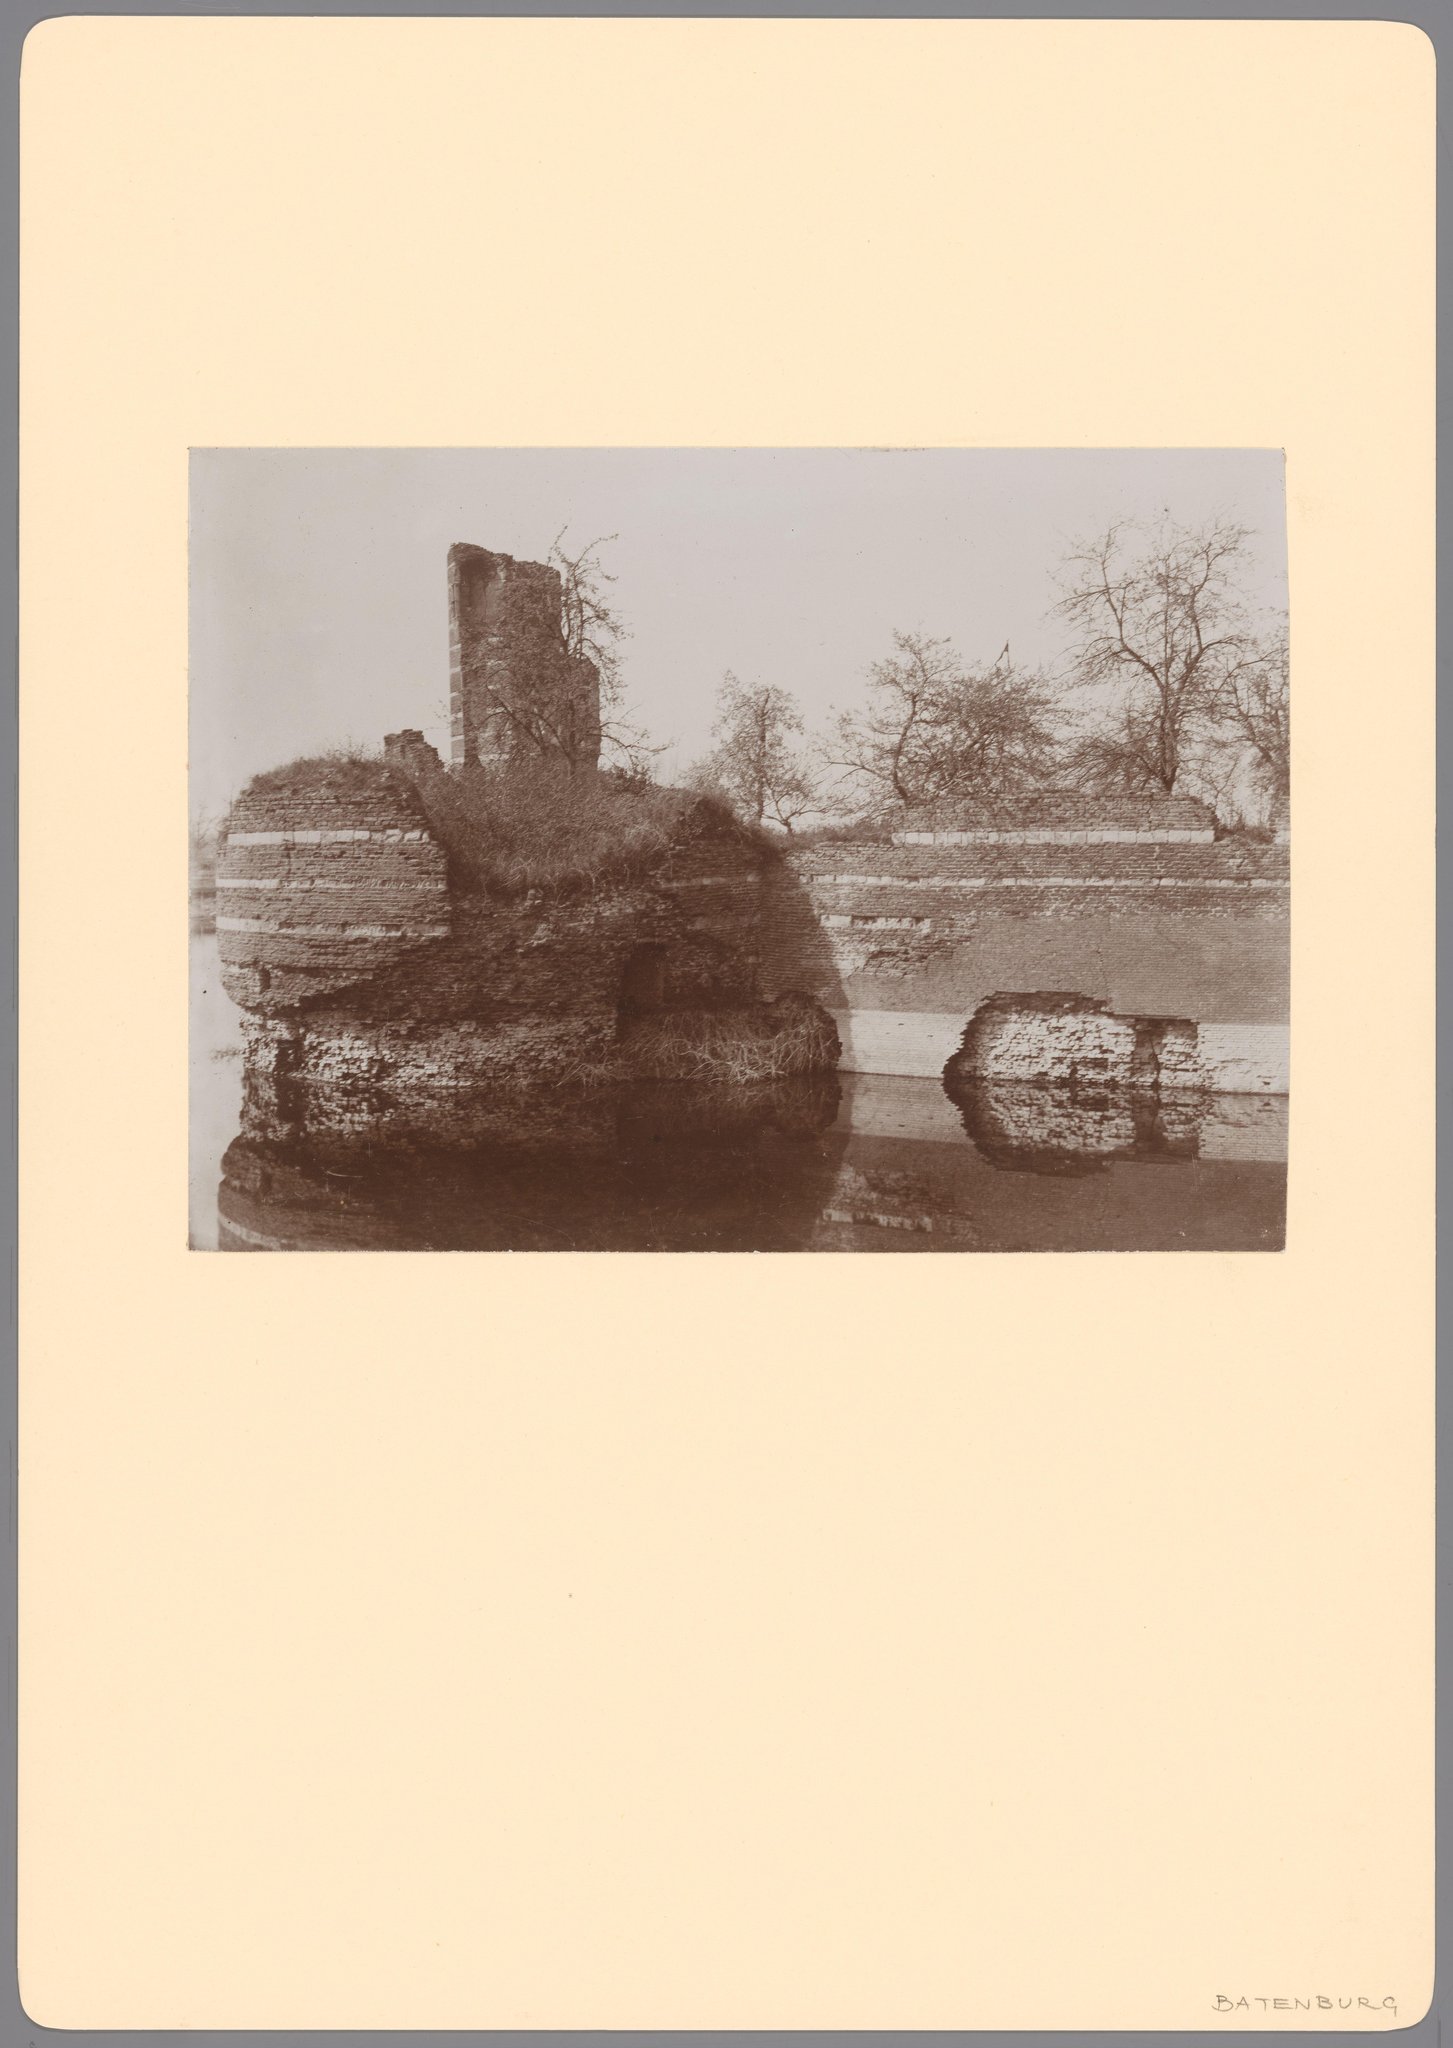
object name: photograph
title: Gedeelte van de kasteelruïne te Batenburg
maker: anoniem (monumentenzorg)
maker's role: fotograaf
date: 1906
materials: cardboard, photographic support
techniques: collodion silver print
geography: batenburg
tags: ruin of a dwelling, house, castle, etc.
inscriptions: annotation: ‘Batenburg’, annotation: ‘Kasteel Batenburg (G.)’